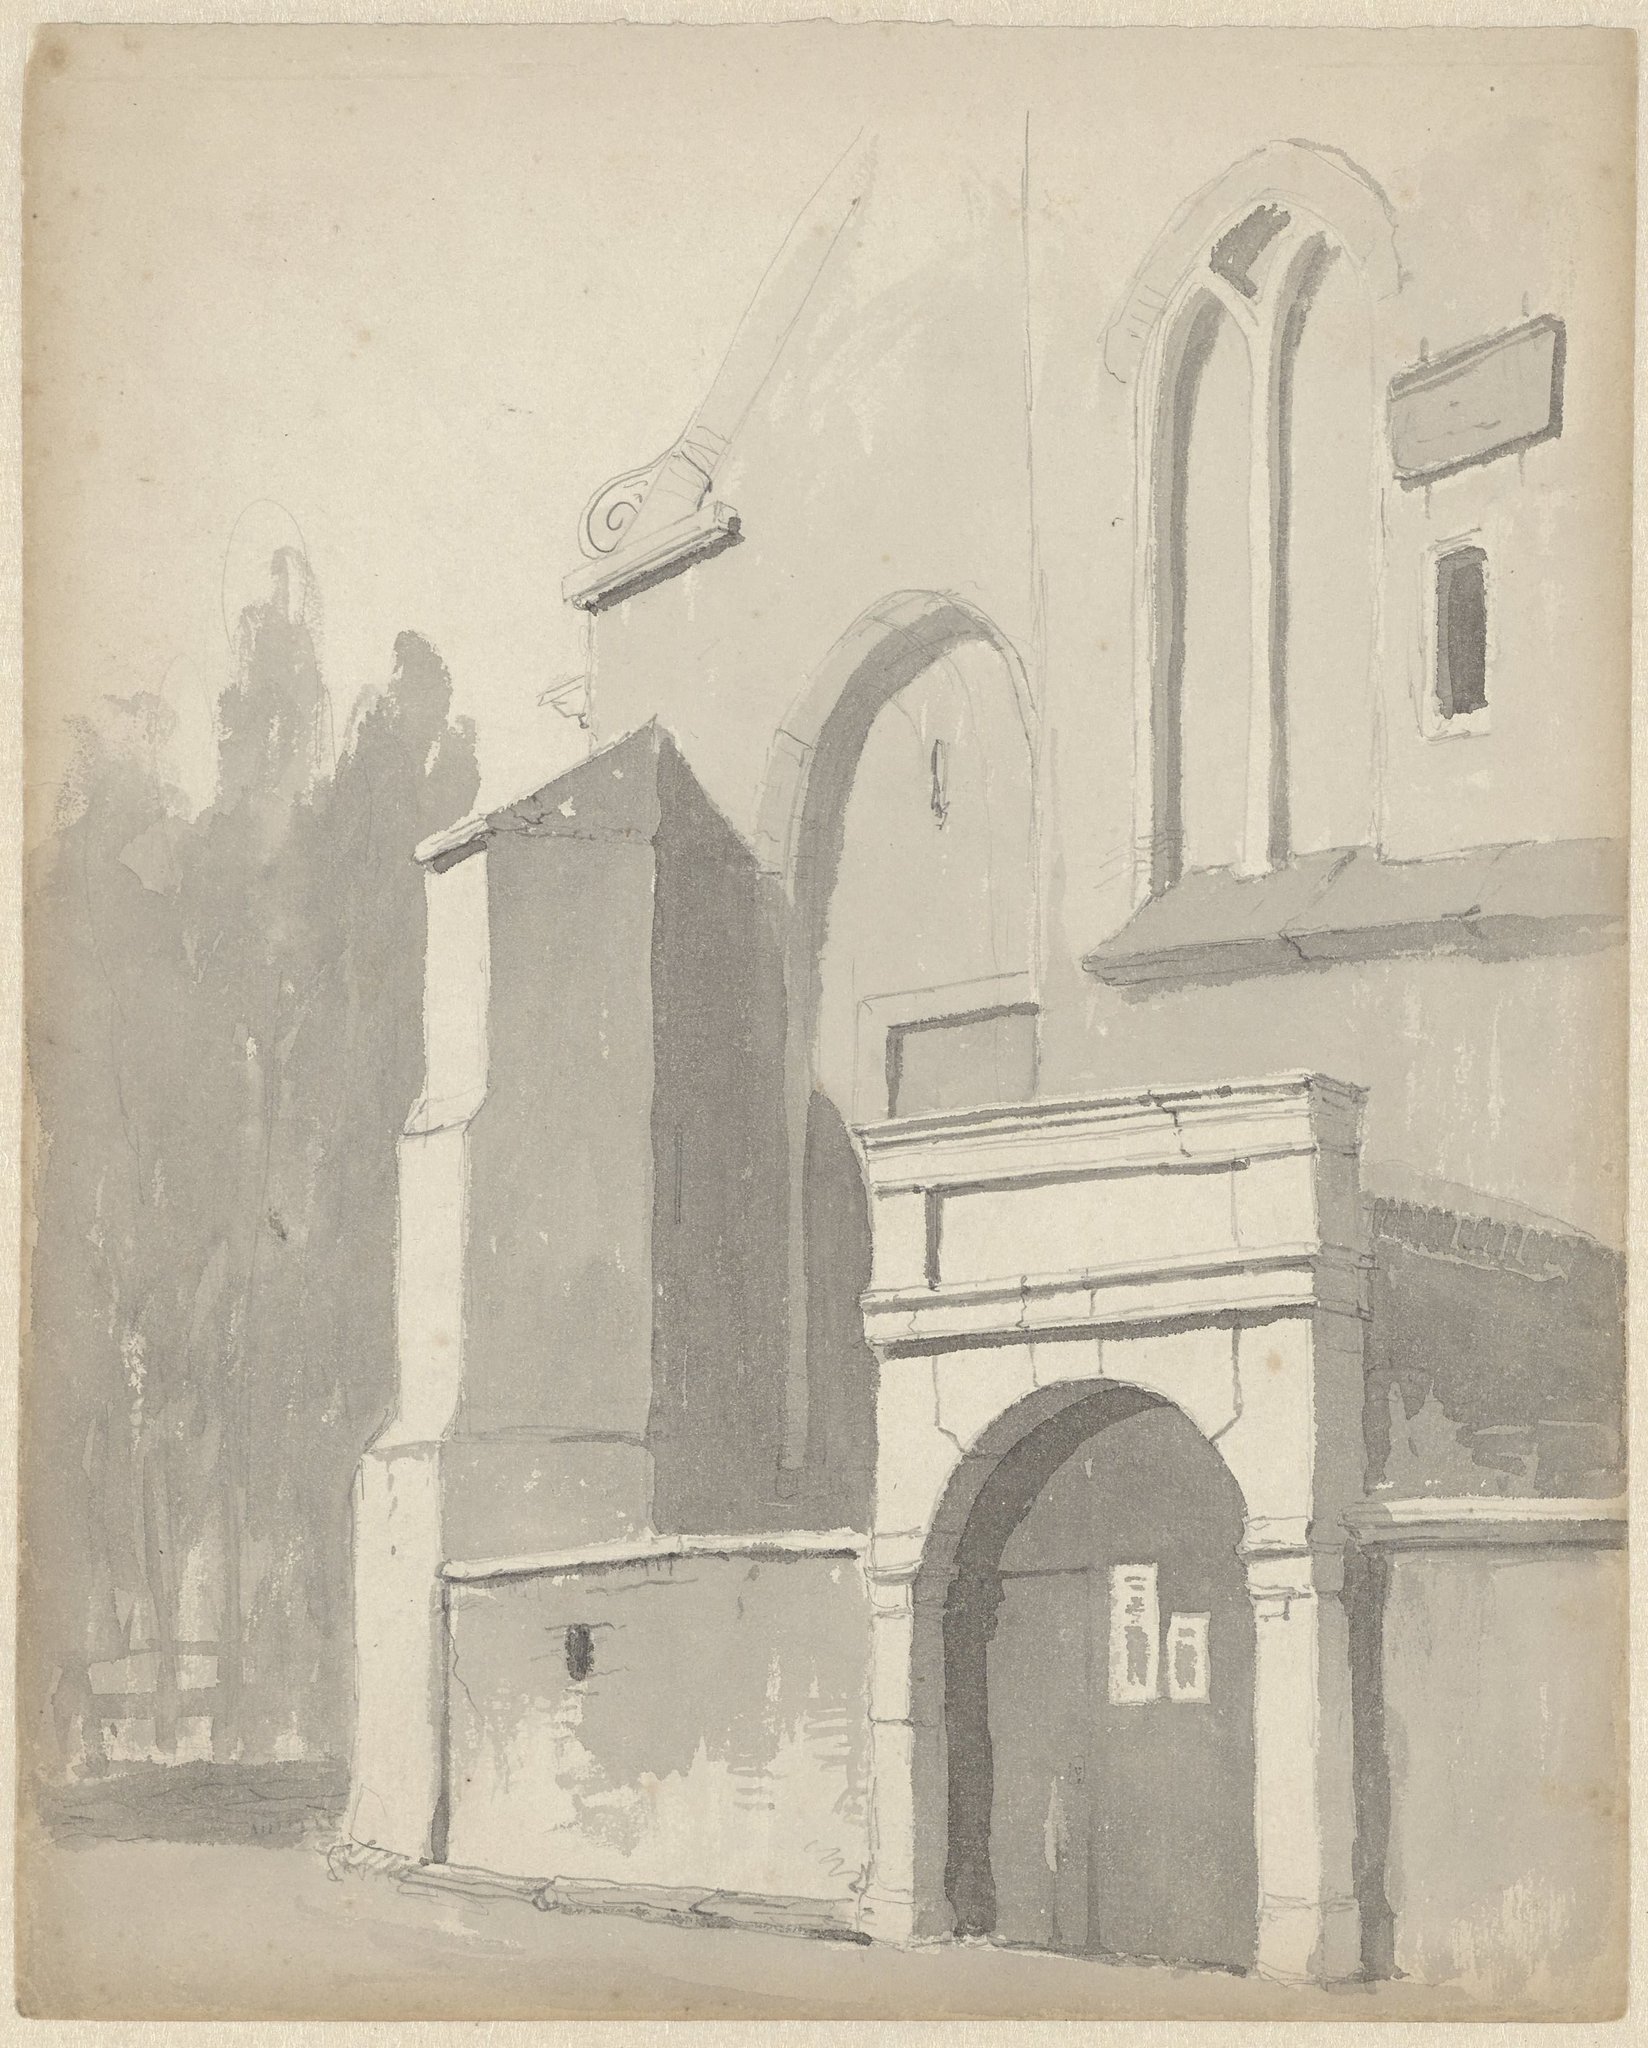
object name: drawing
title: Gezicht op een ingangspoortje van een kerk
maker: adrianus eversen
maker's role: draughtsman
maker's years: 1818-1897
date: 1828-1897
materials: paper, pencil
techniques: brush